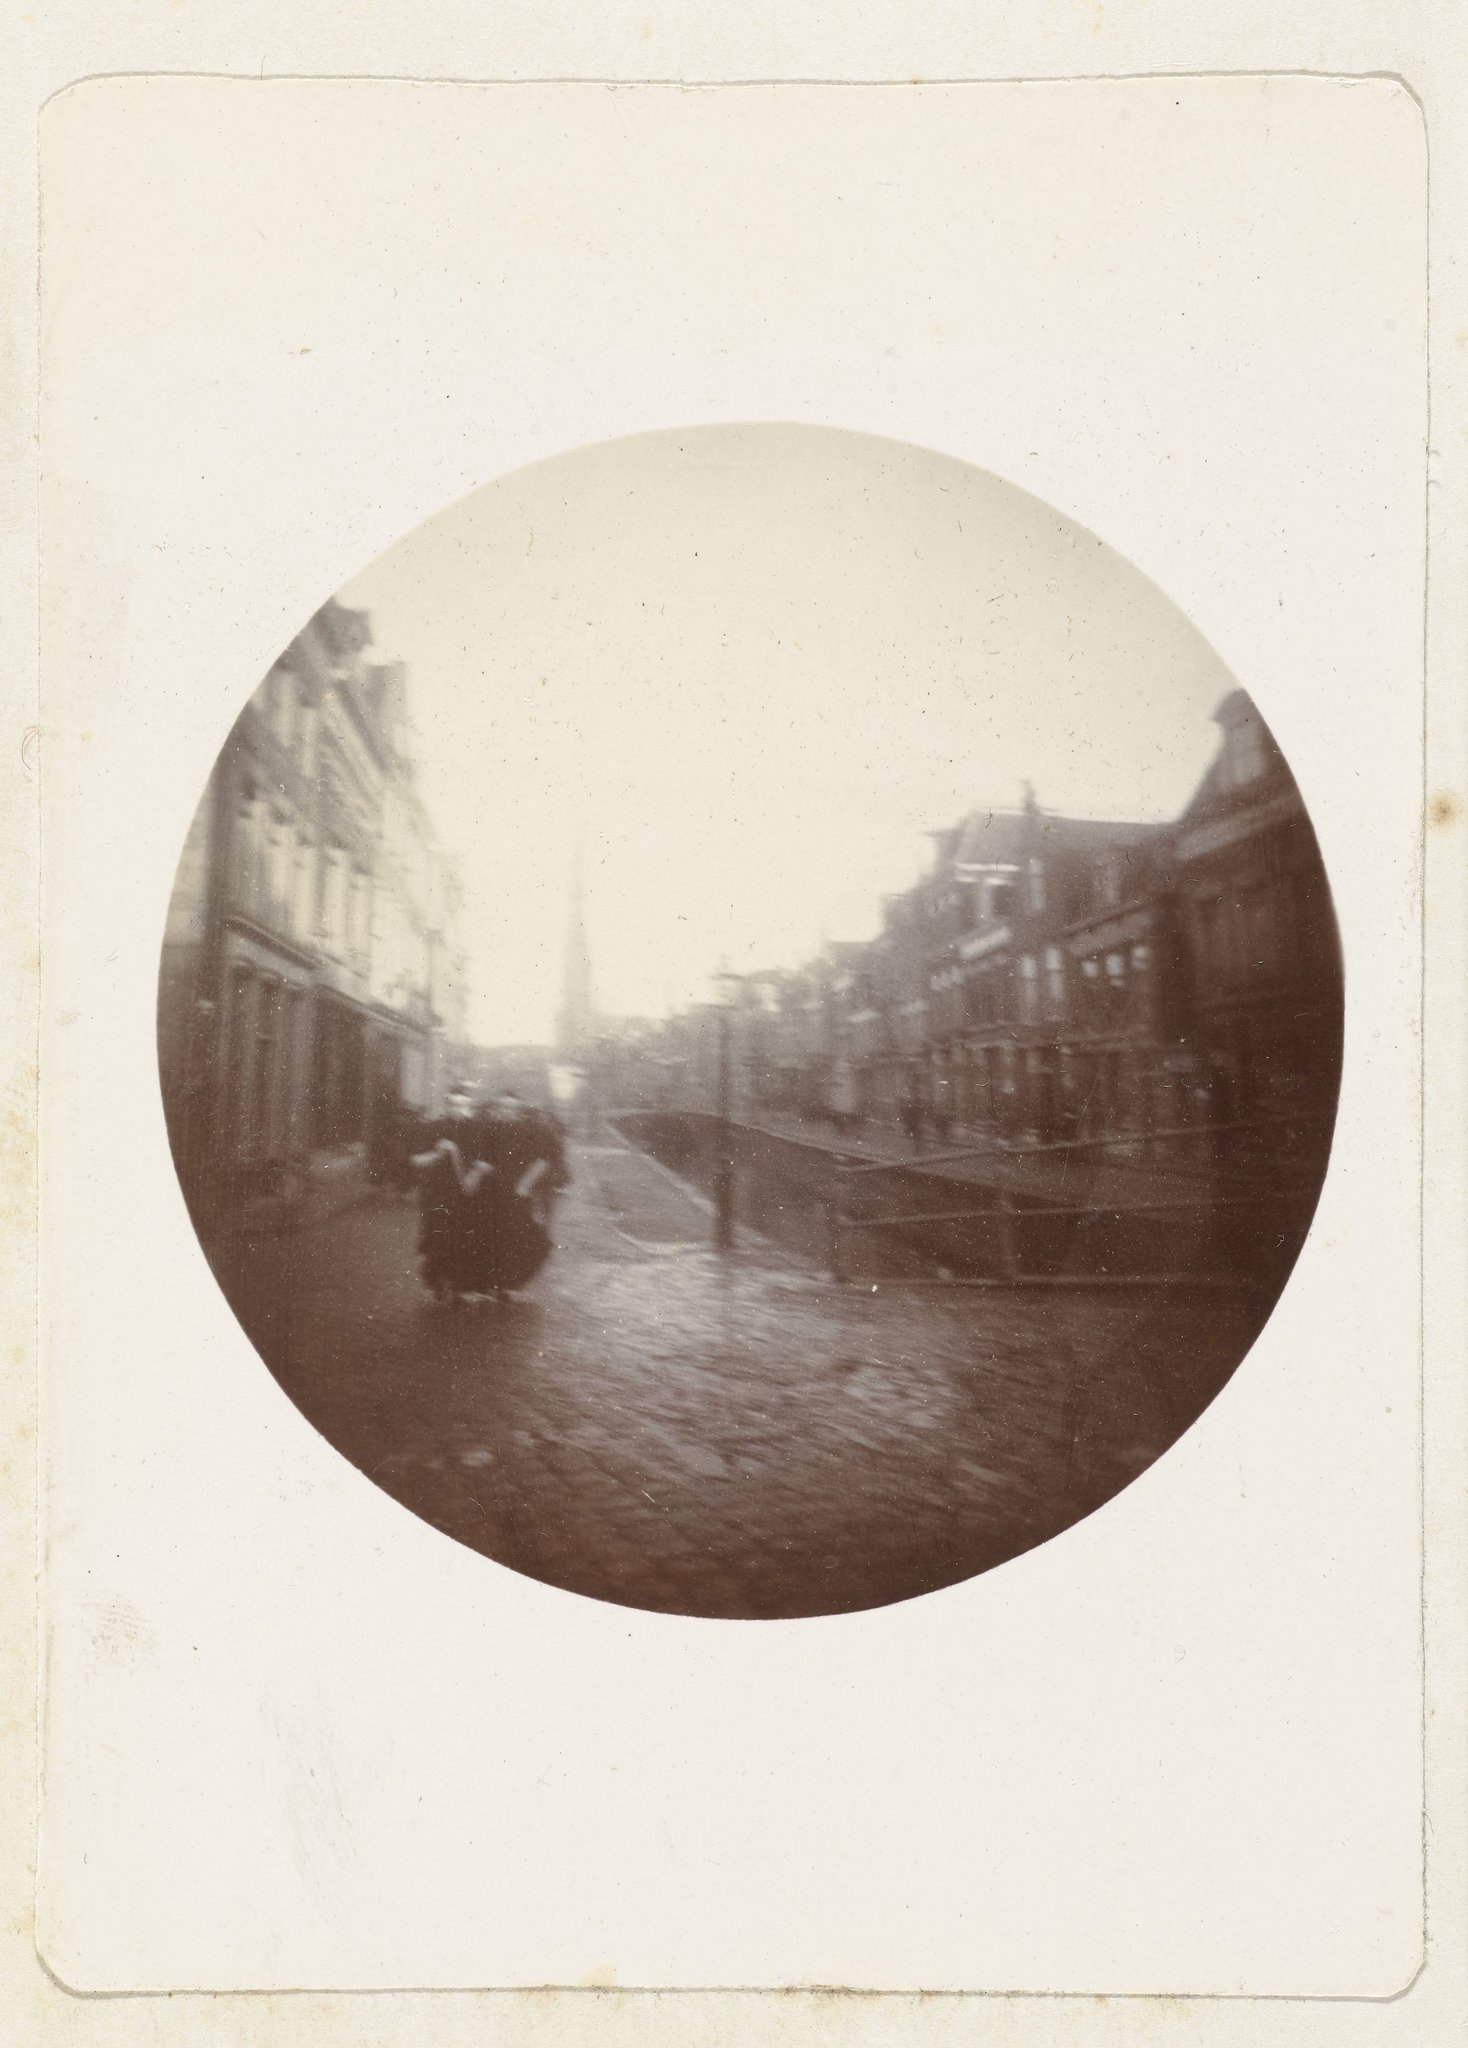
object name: photograph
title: Leeuwarden 1897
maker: Anonymous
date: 1897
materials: paper, cardboard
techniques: gelatin silver print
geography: leeuwarden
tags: street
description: De Voorstreek gezien vanaf de hoek Minnemastraat, met op de achtergrond de Bonifatiuskerk. De foto is onderdeel van een albumblad met daarop foto's van Leeuwarden.